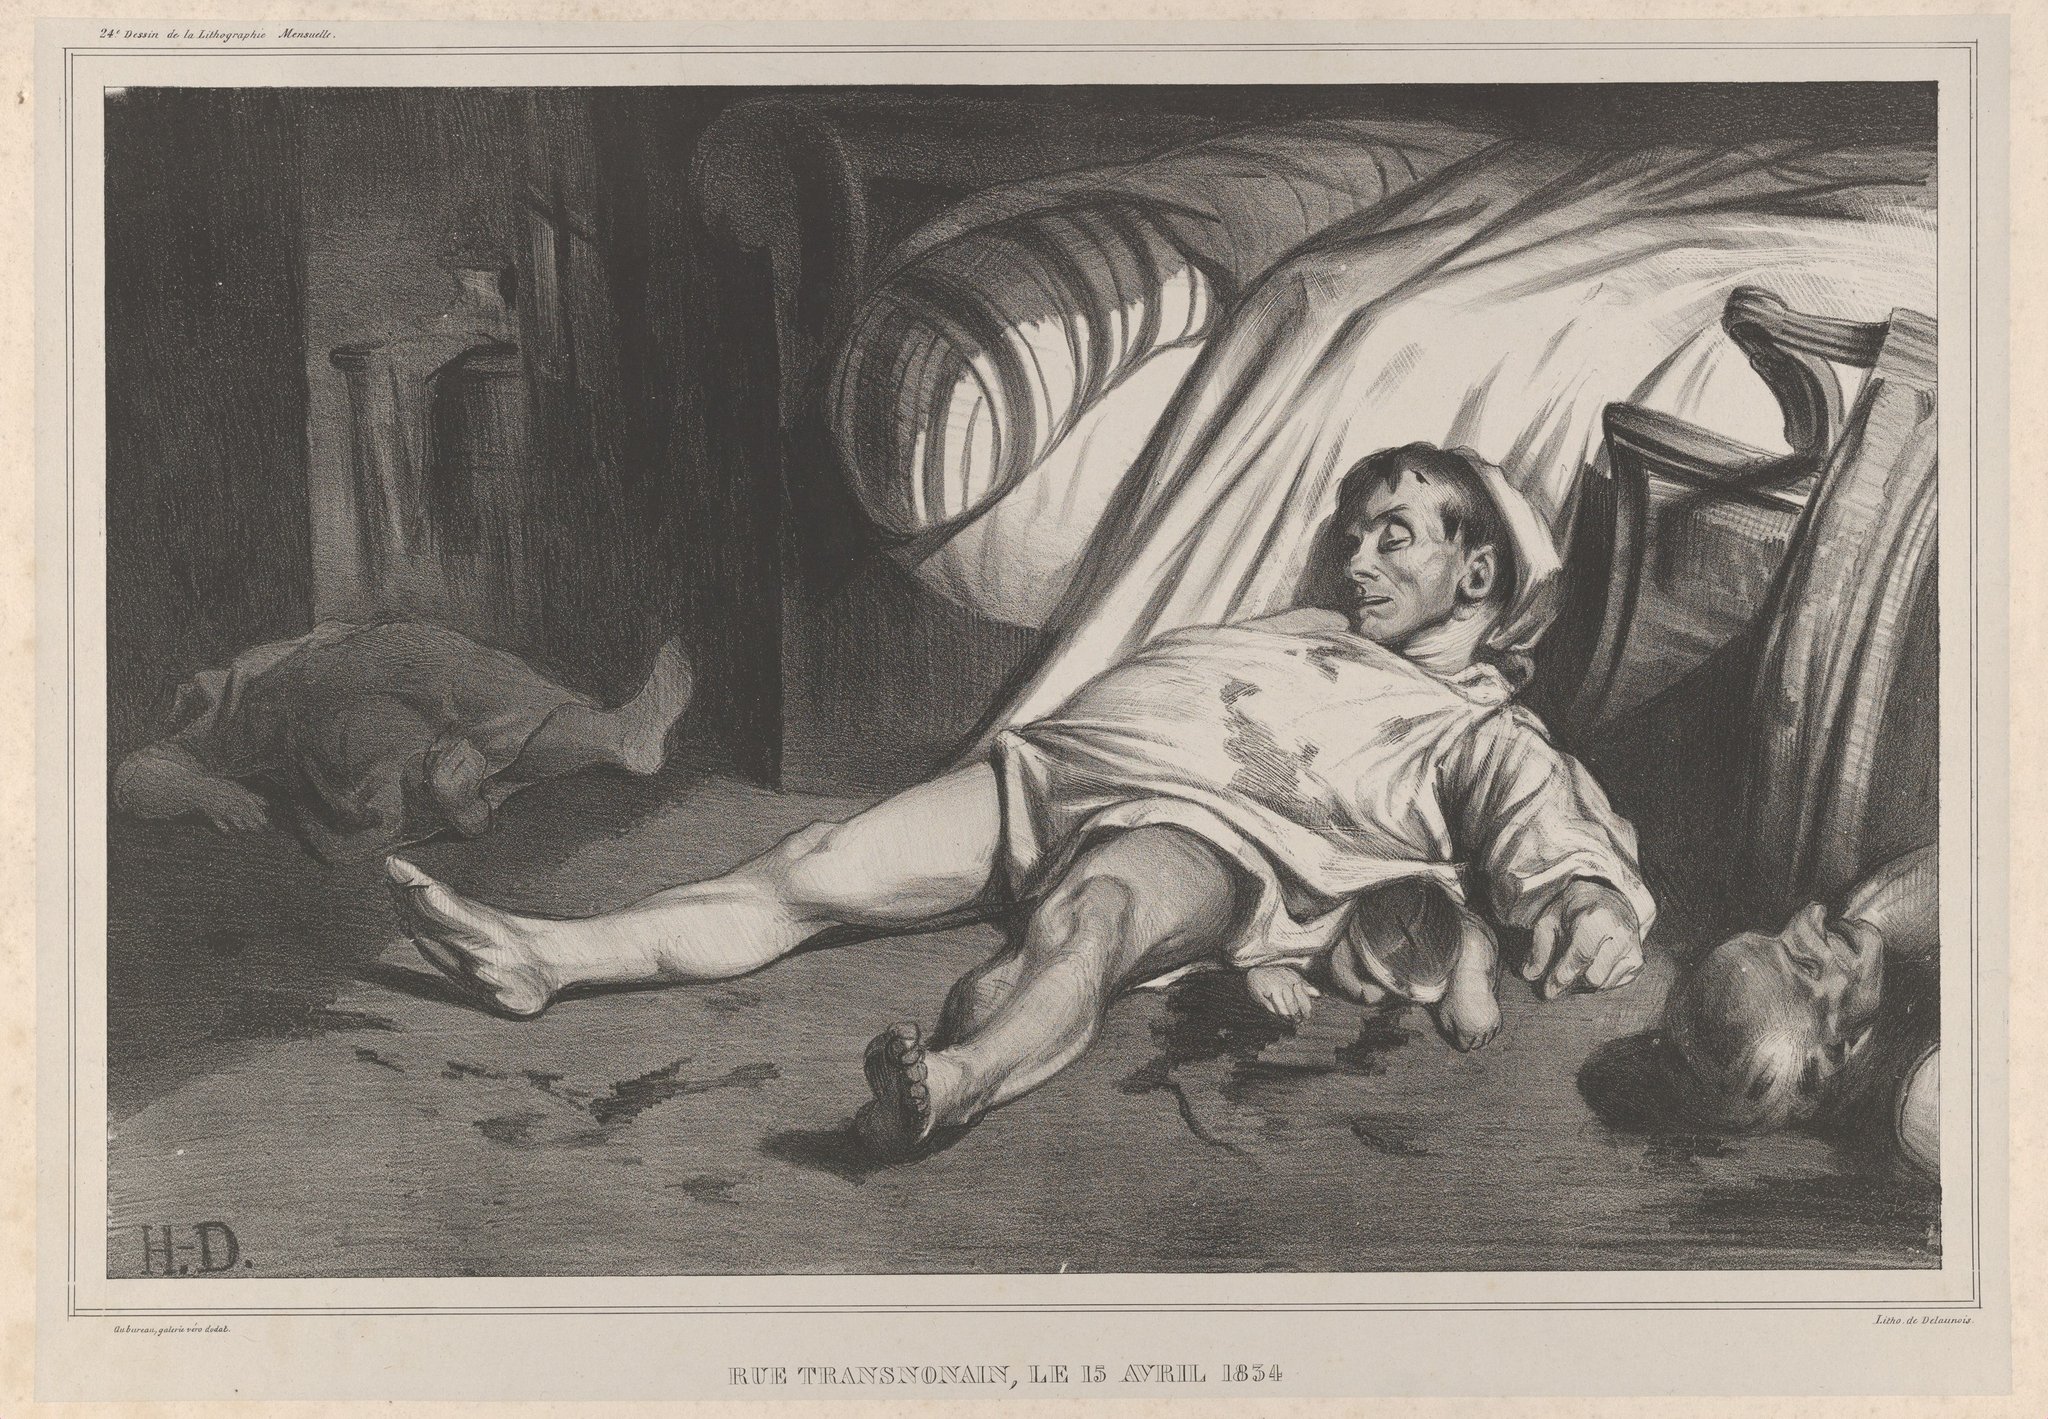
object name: print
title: Rue Transnonain, le 15 Avril, 1834, Plate 24 of l'Association mensuelle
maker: honoré daumier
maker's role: artist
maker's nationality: french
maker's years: 1808-1879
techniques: lithograph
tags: men,women,death